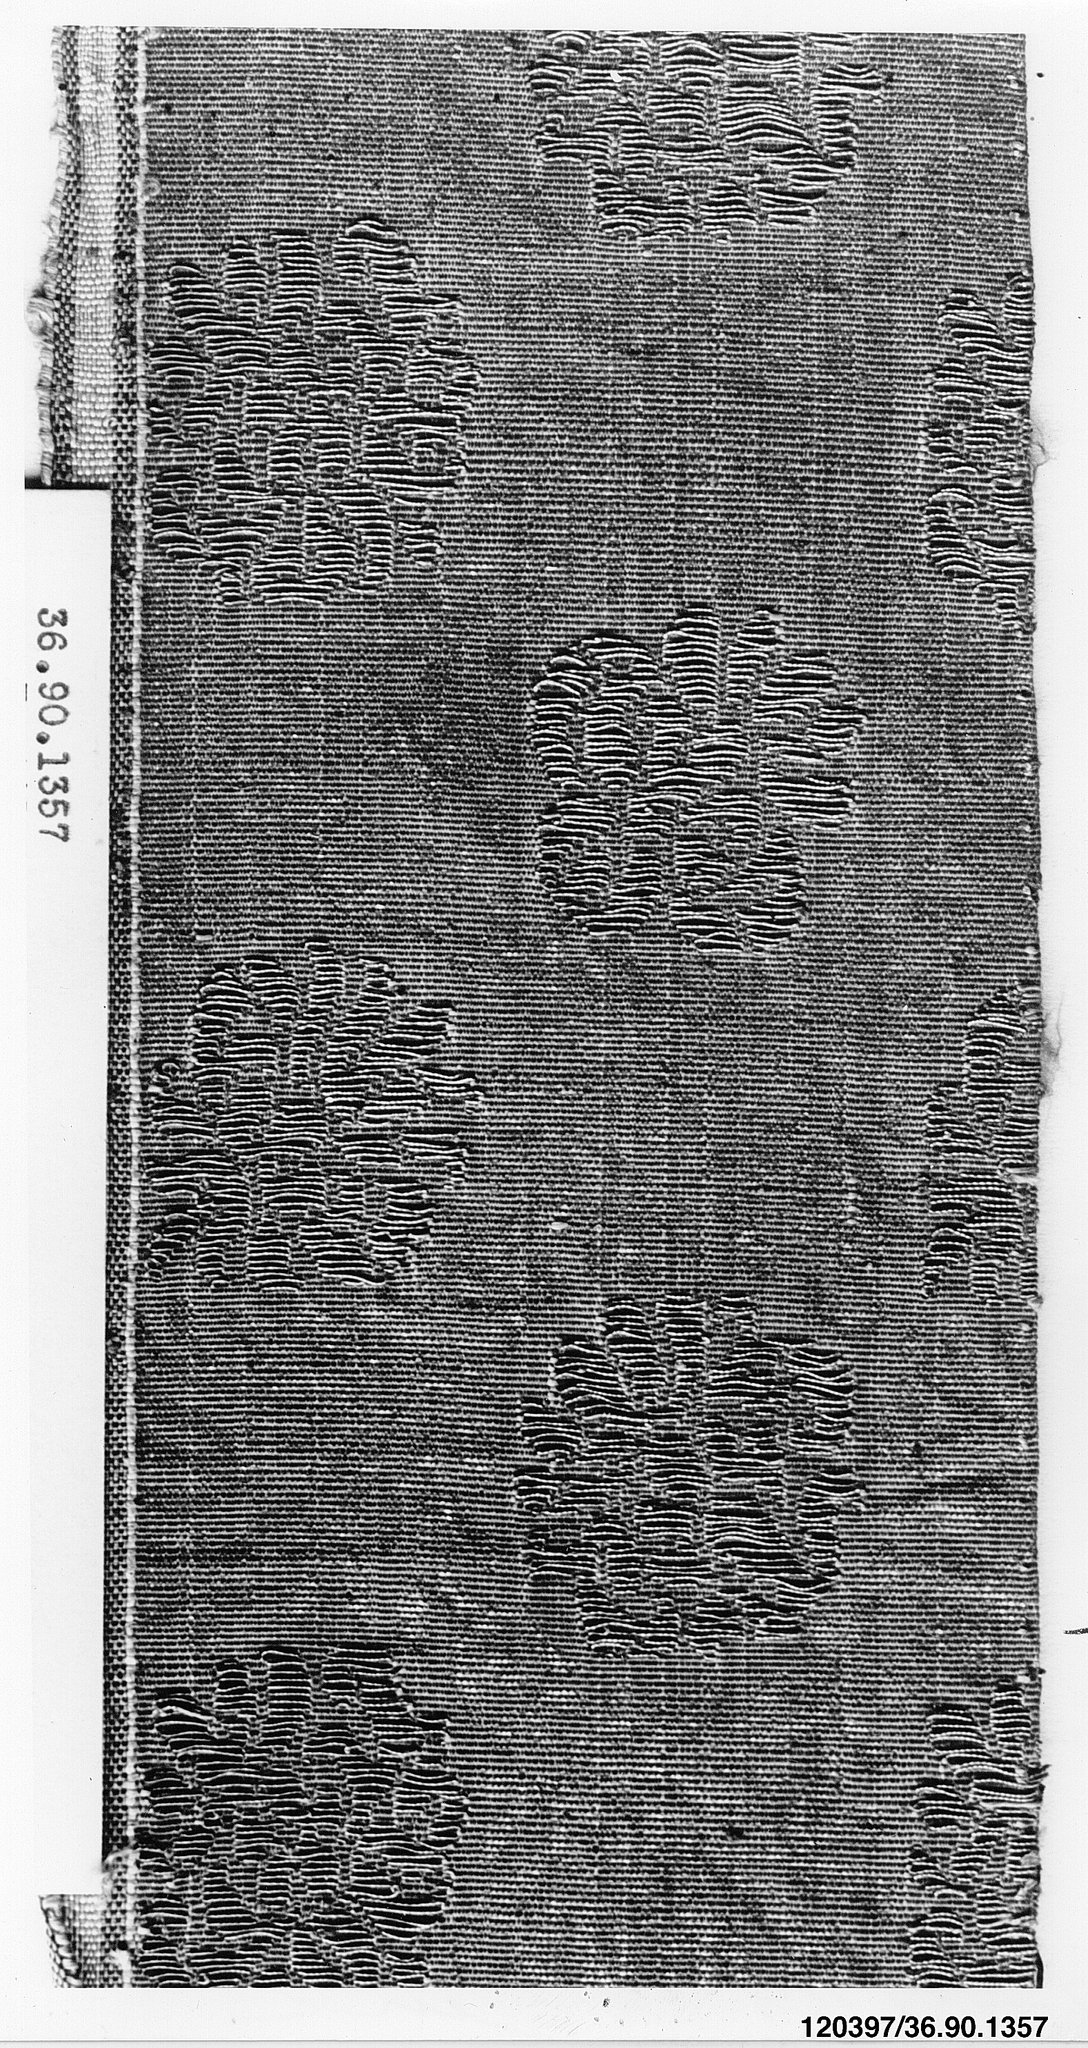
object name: piece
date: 1501-1600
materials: metal thread, silk